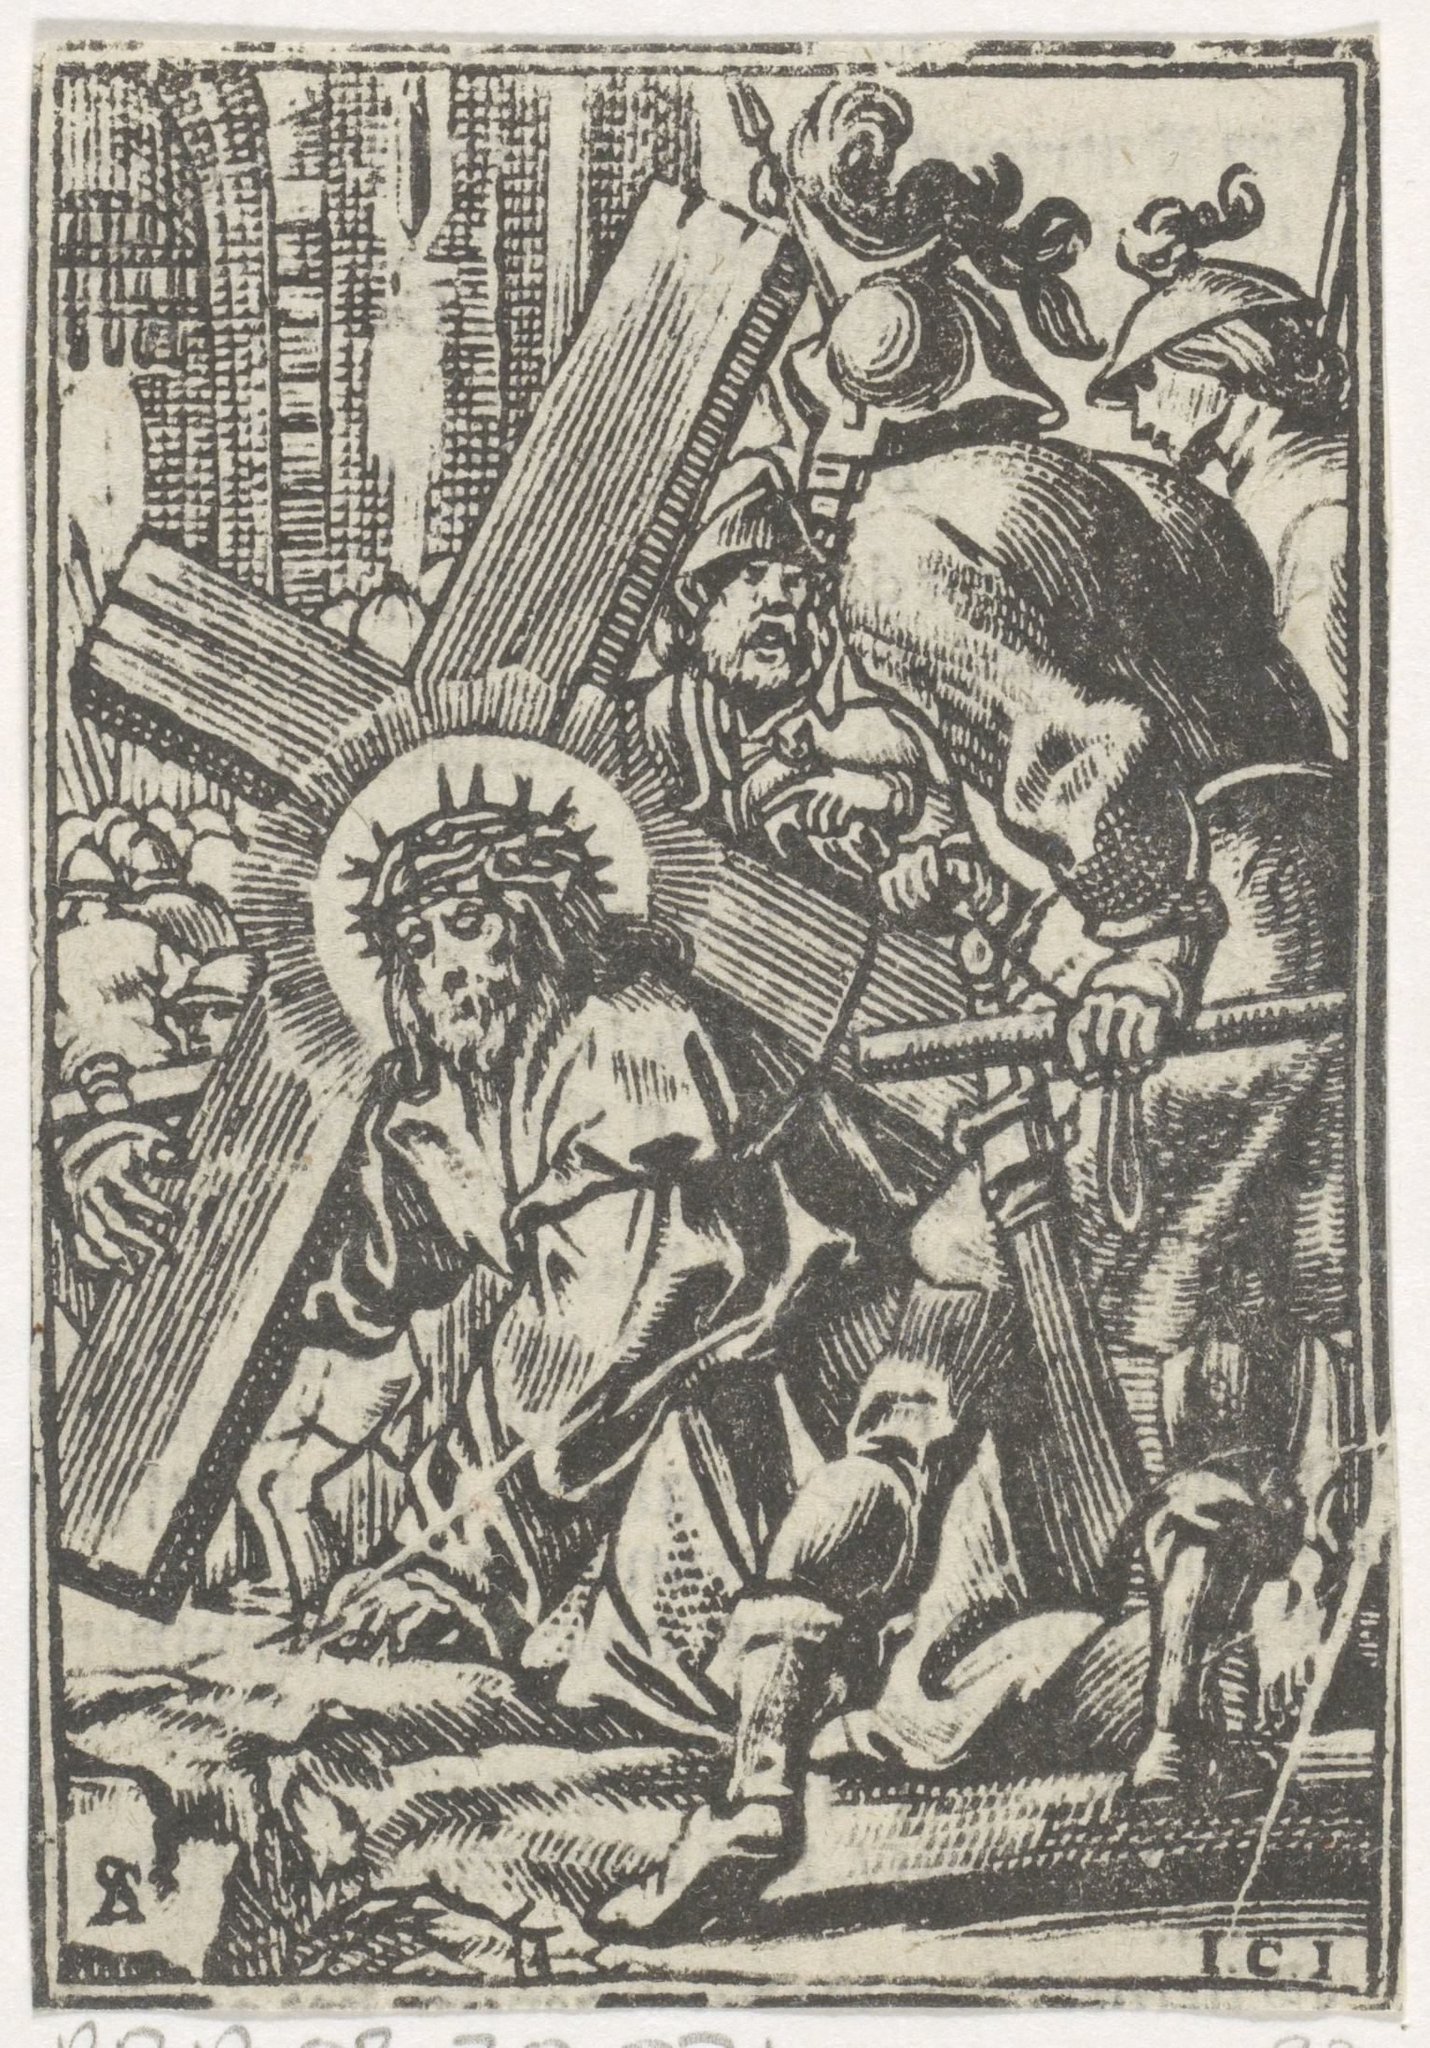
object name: print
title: Christus bezwijkt voor tweede keer tijdens de kruisdraging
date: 1649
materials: paper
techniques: letterpress printing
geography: antwerp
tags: second fall ~ christ carrying the cross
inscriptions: collector's mark: Lugt 2228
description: Prent uit: Andries, Judocus. Perpetua crux sive passio Jesu Christi. Antwerpen: Cornelis Woons, 1649.